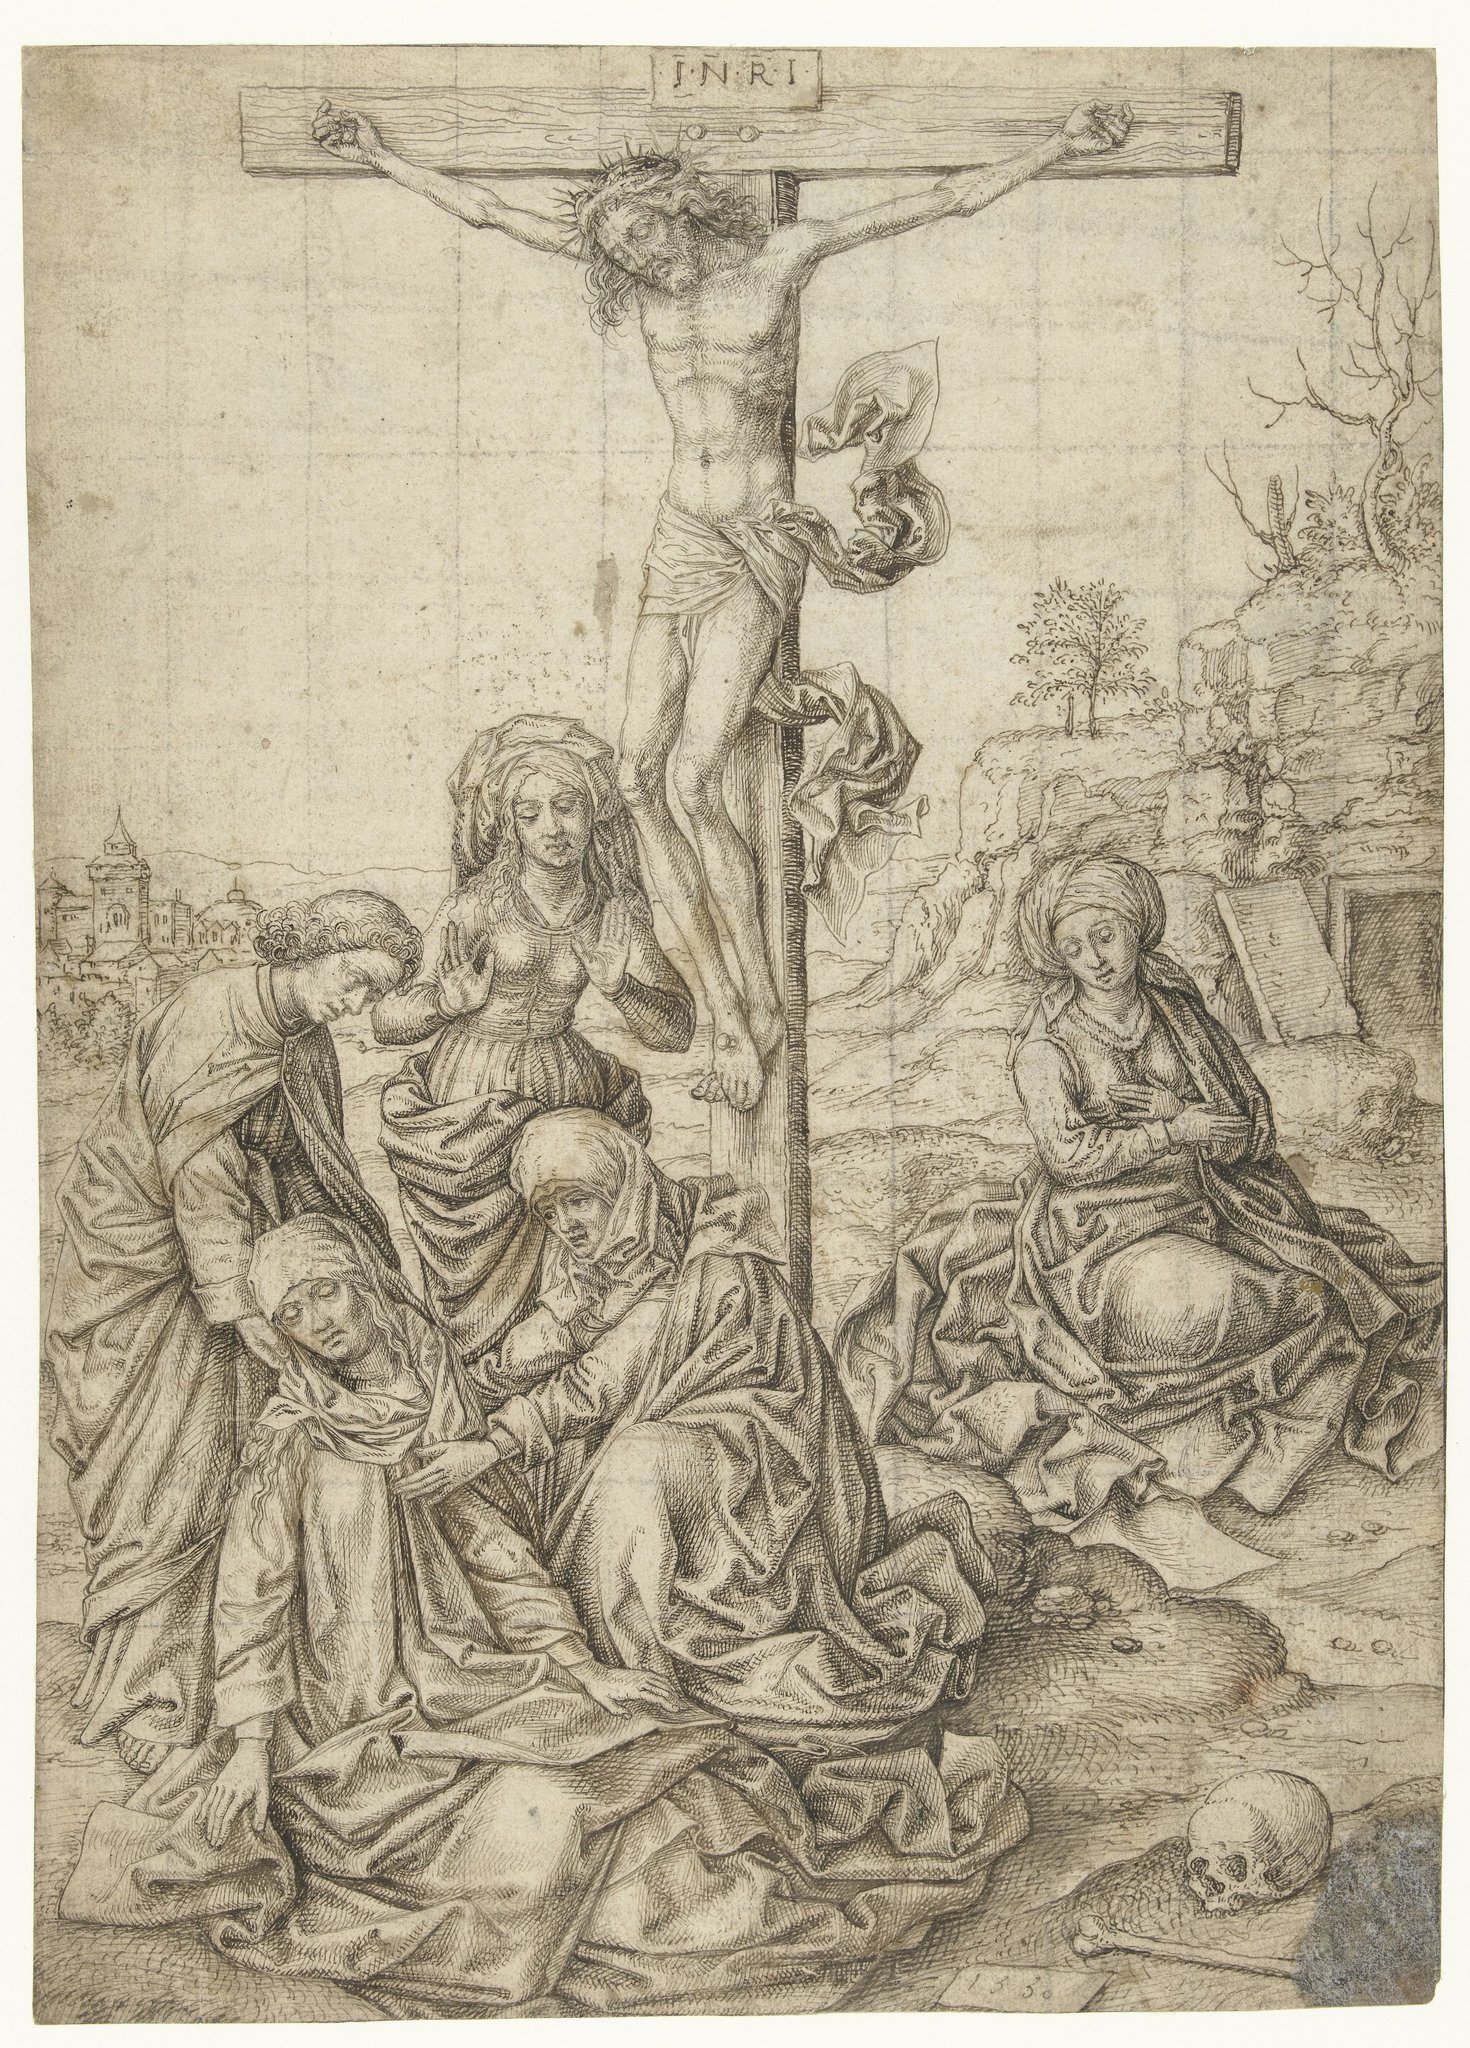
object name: design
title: Christus aan het kruis met Johannes, de drie Maria's en Maria Magdalena onder het kruis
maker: pieter huys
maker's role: draughtsman, painter, print maker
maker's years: 1509-1591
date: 1550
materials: ink, paper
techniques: pen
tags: crucified christ with other persons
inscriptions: date